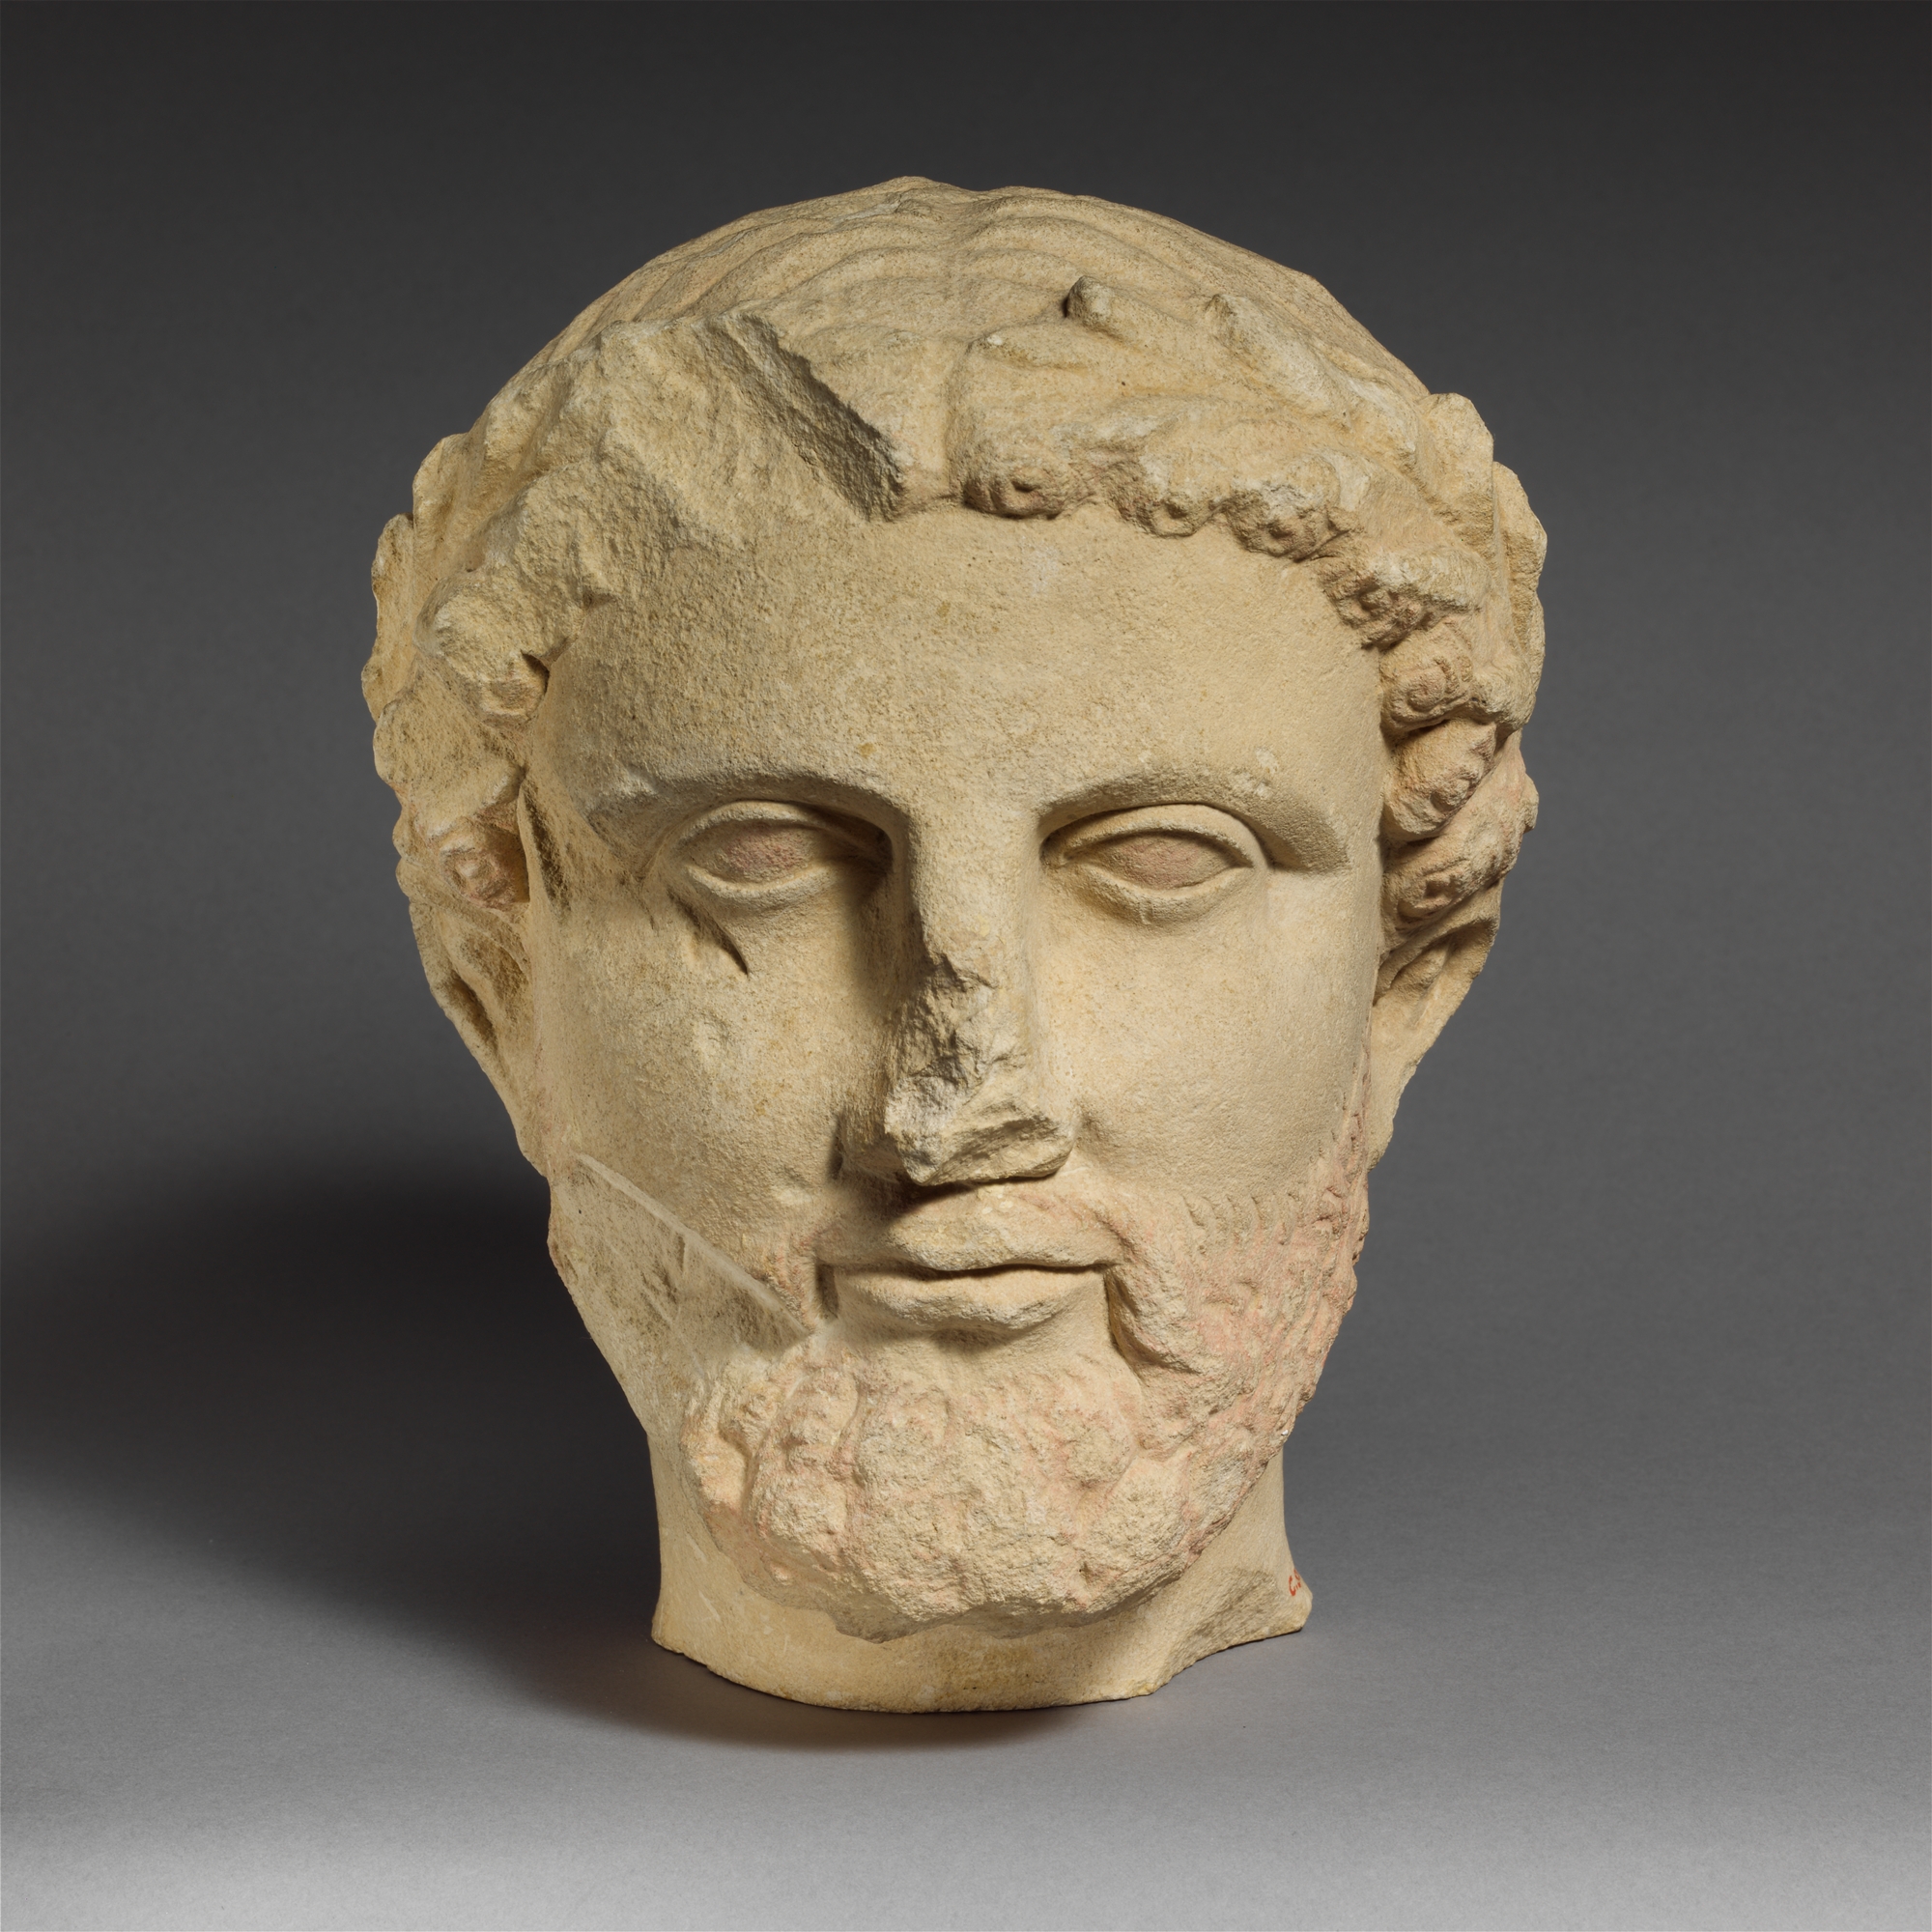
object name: head of a man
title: Limestone bearded head with a wreath of leaves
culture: cypriot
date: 200-101 BCE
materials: limestone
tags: heads,men,wreaths